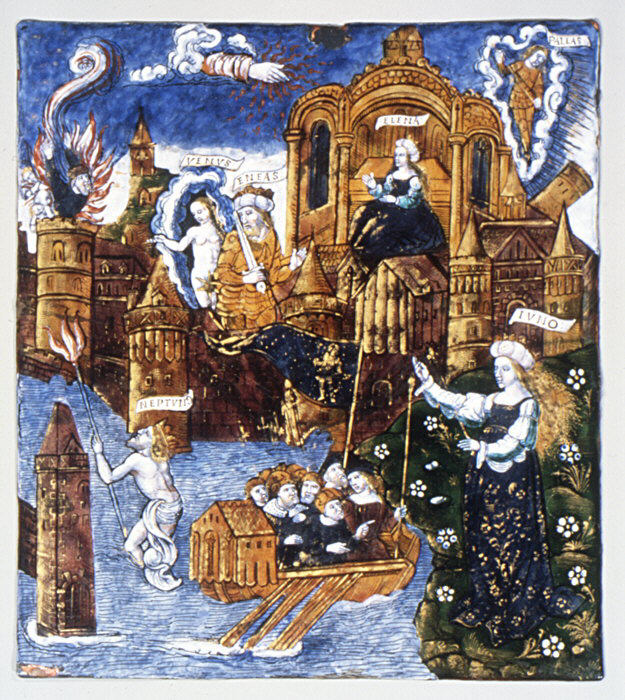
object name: plaque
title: The Fall of Troy; Helen Takes Refuge in the Sanctuary of Vesta; Venus Counsels Aeneas; Juno Encourages the Greeks (Aeneid, Book II)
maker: master of the aeneid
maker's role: artist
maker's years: 1525-1545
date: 1530-1535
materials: copper, enamel, gilt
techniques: painting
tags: castles,aeneas,juno,venus